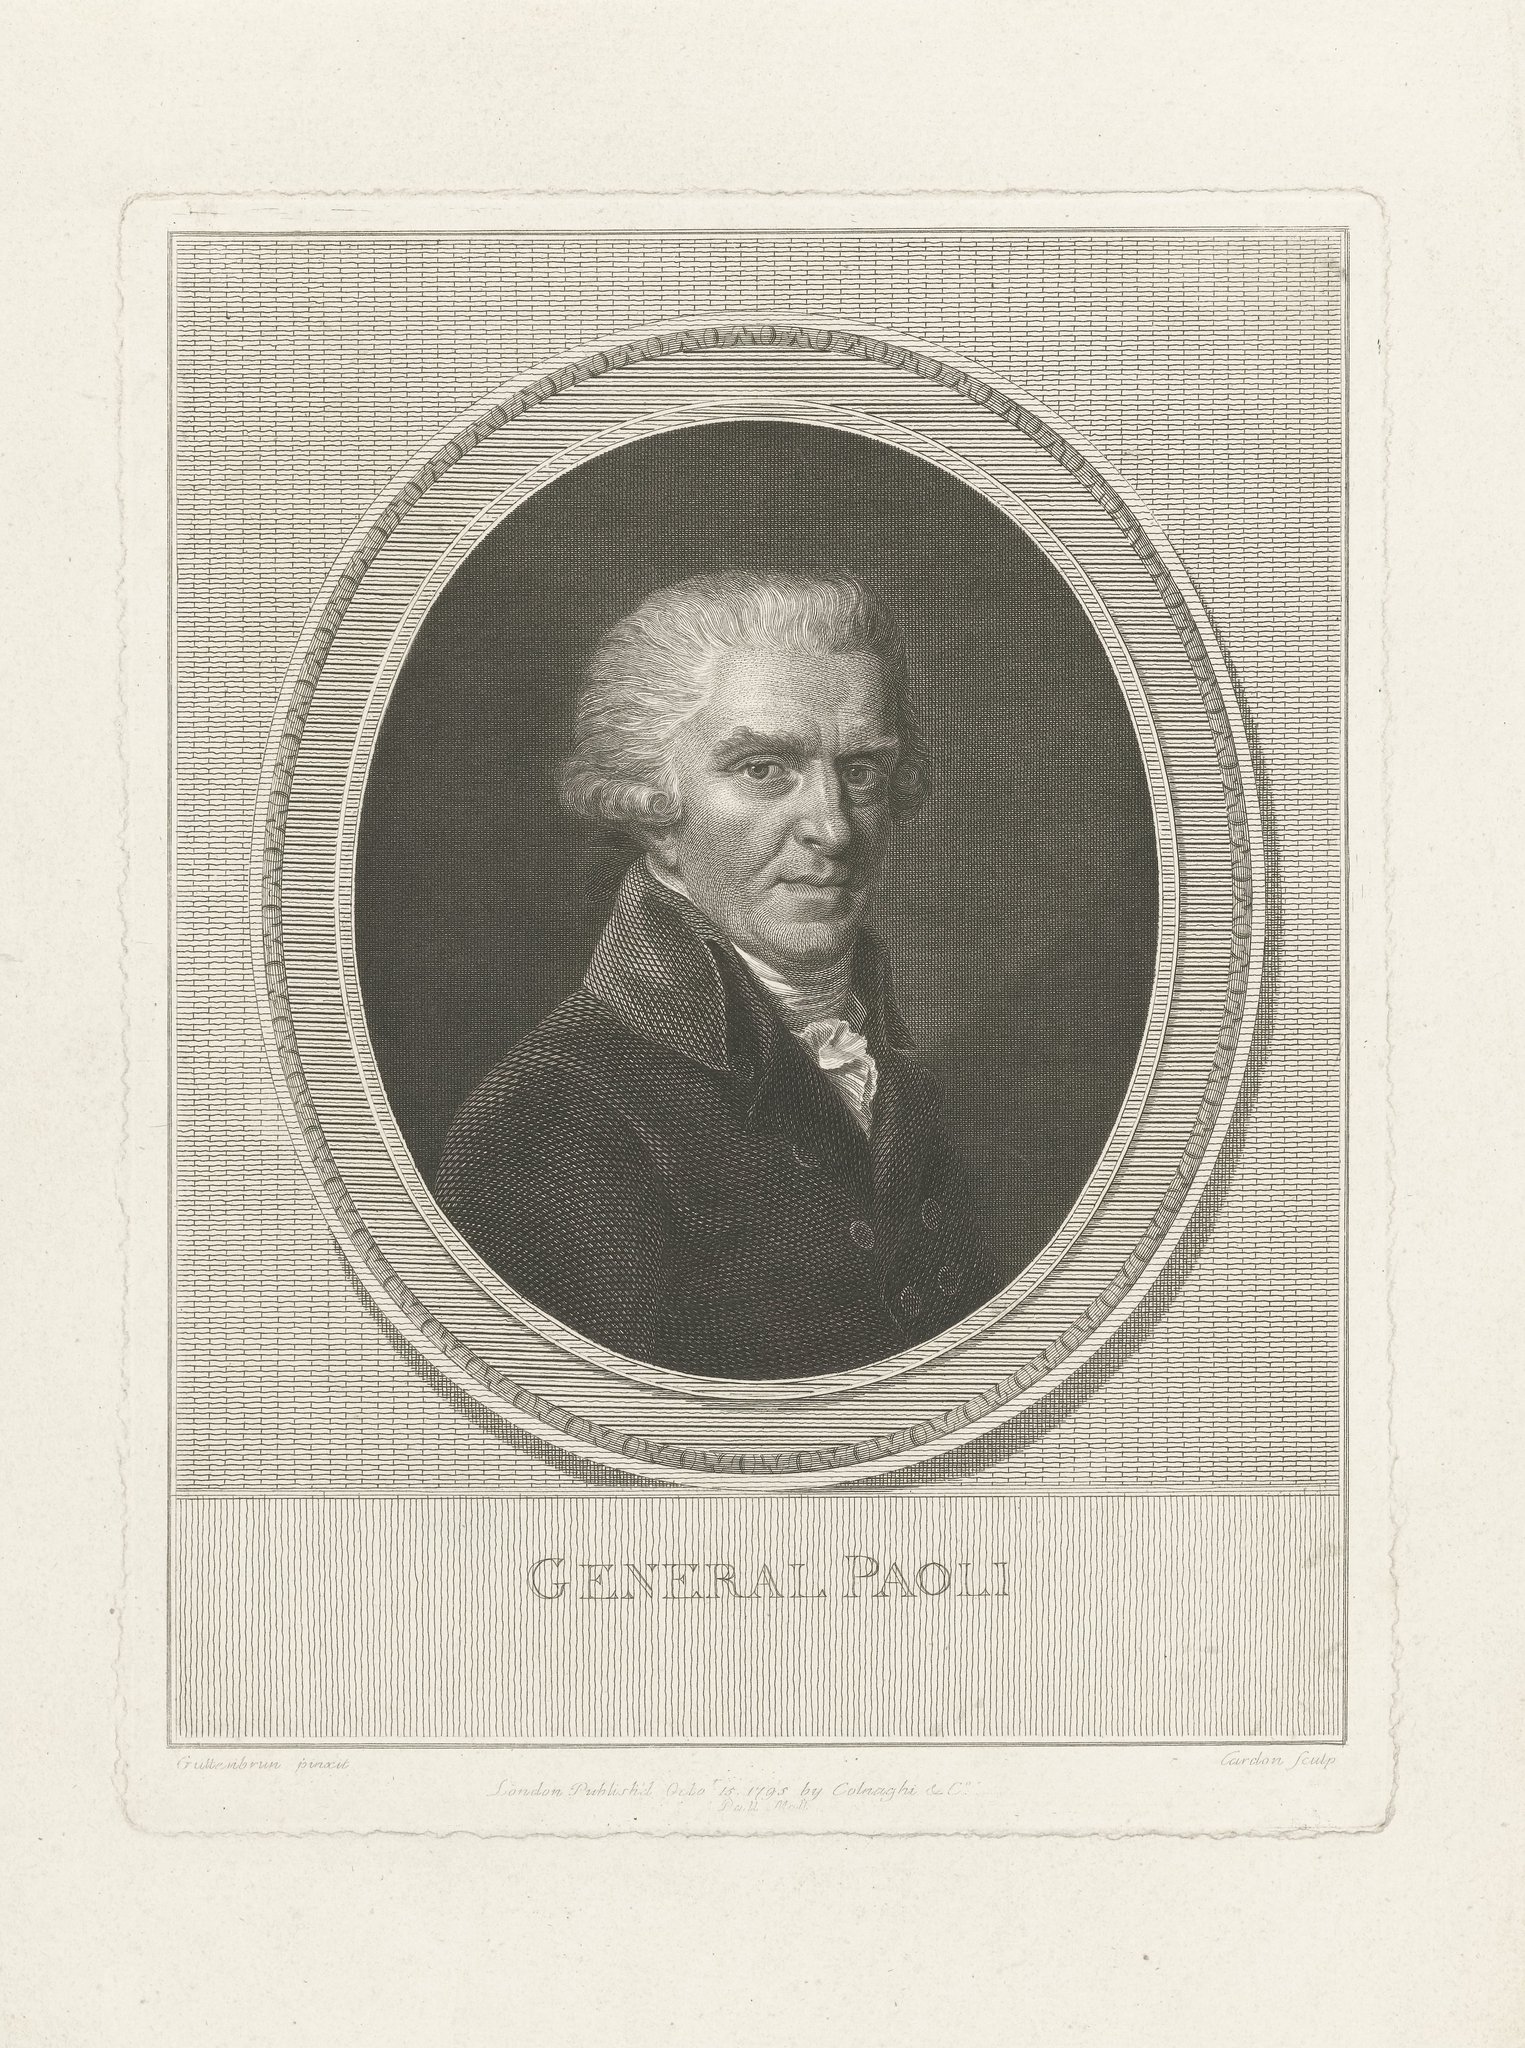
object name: print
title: Portret van generaal Pascal Paoli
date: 1795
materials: paper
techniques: etching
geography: london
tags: london, commander-in-chief, general, marshal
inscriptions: collector's mark: Lugt 2228